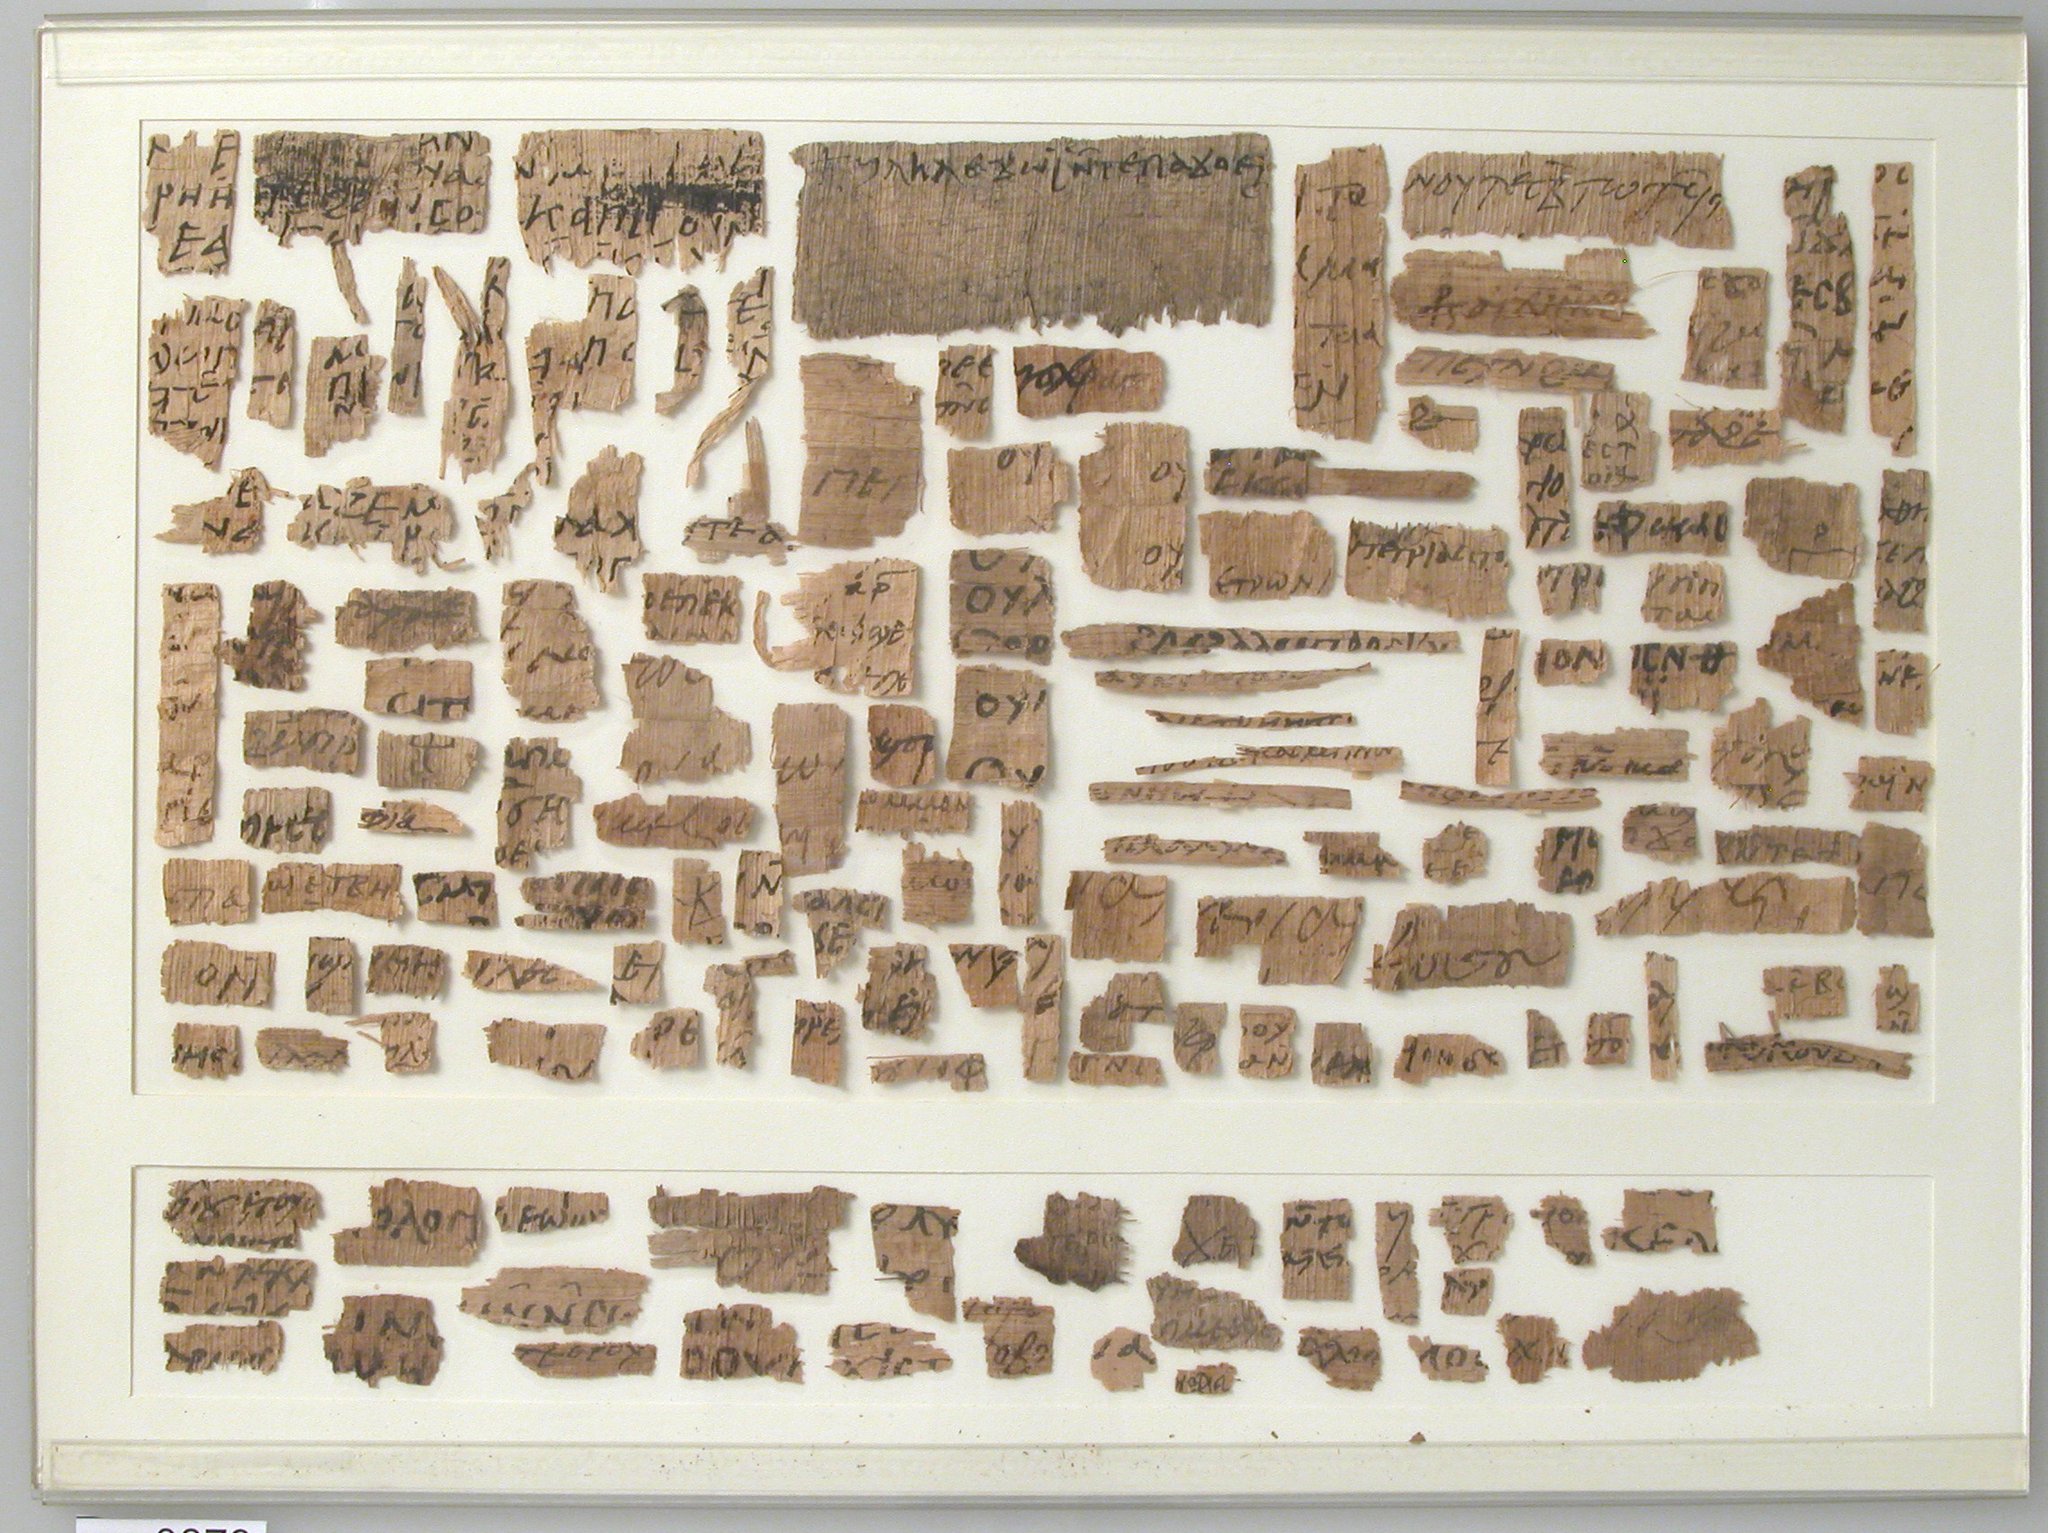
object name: fragment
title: Papyri Fragments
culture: coptic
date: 601-700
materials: ink, papyrus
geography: egypt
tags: documents